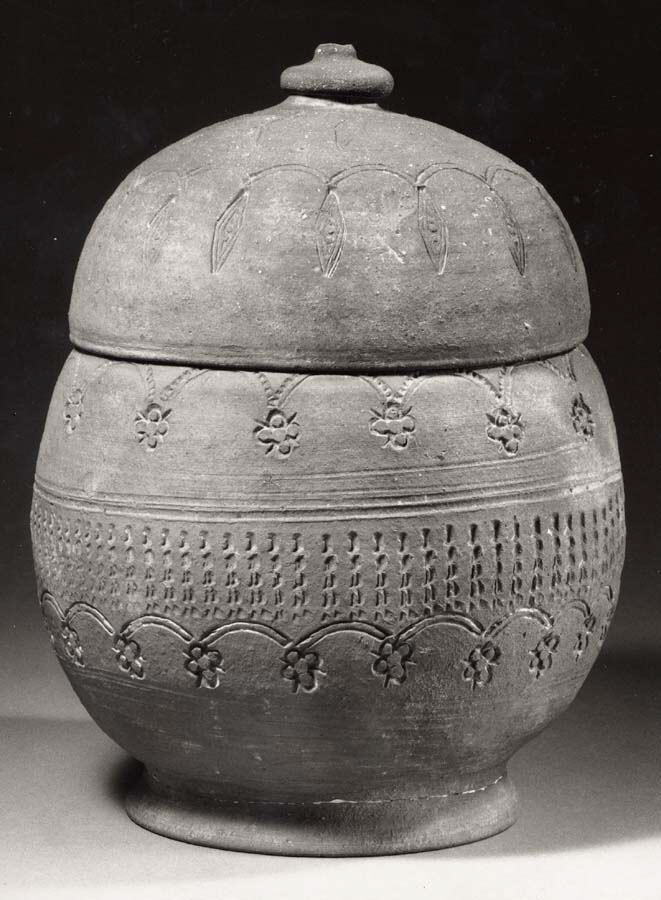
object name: urn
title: Covered Urn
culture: korean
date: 701-900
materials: stoneware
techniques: incising, stamping